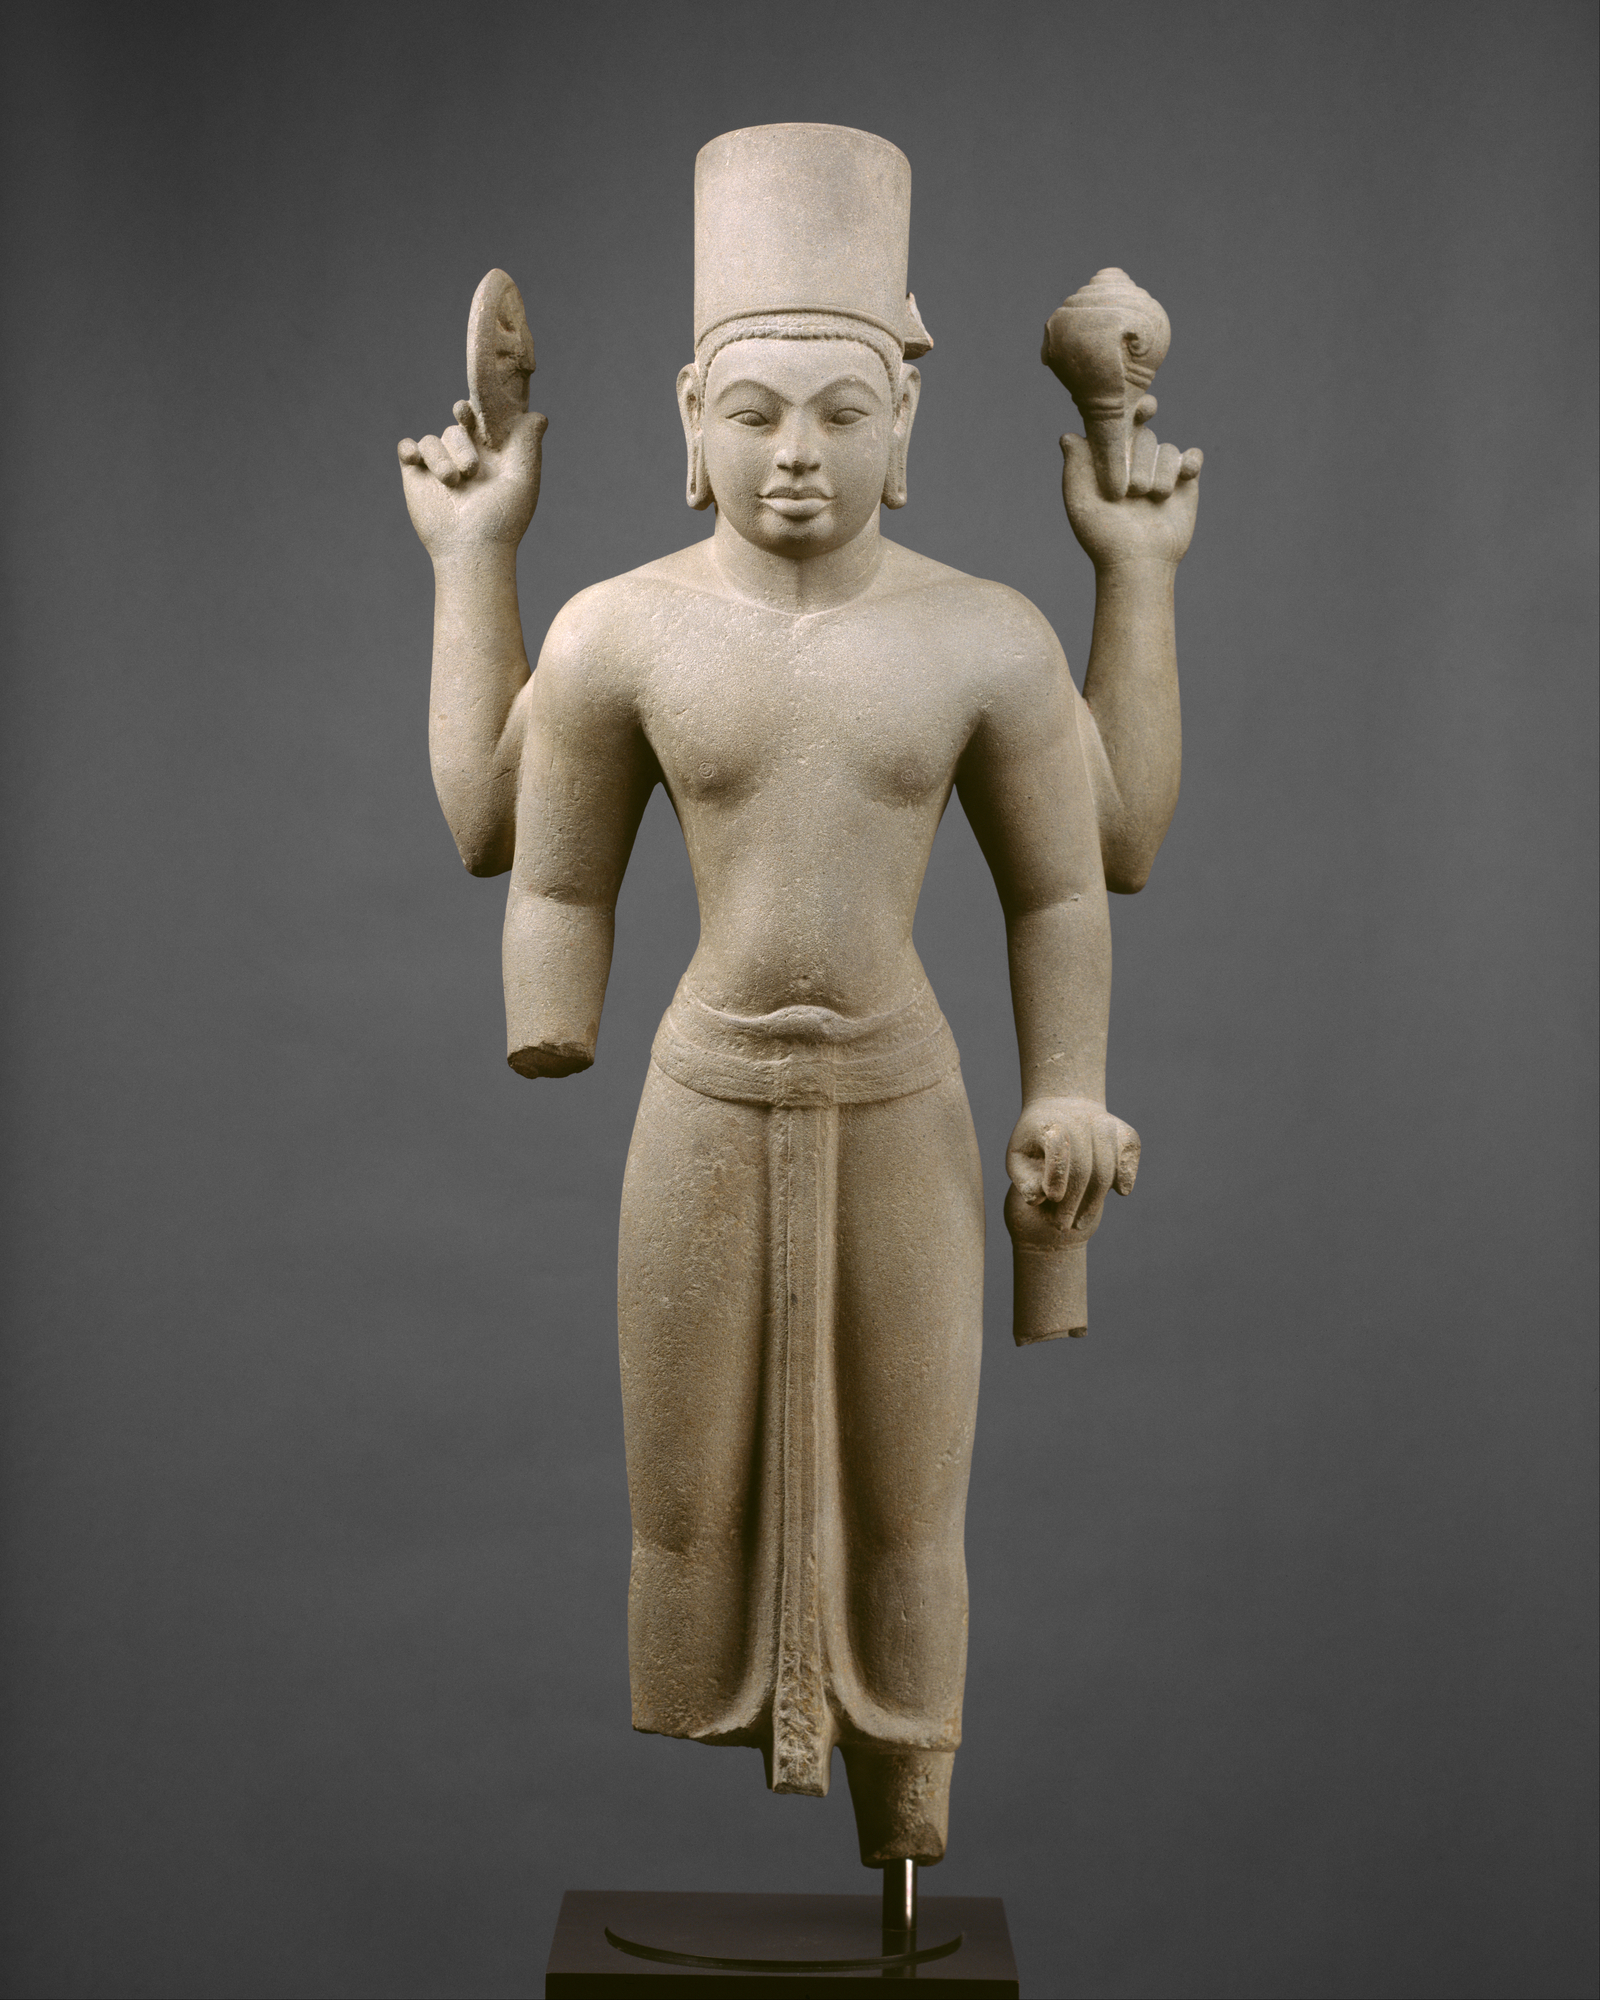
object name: figure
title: Standing Four-Armed Vishnu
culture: vietnamese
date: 651-700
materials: stone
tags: vishnu,hinduism